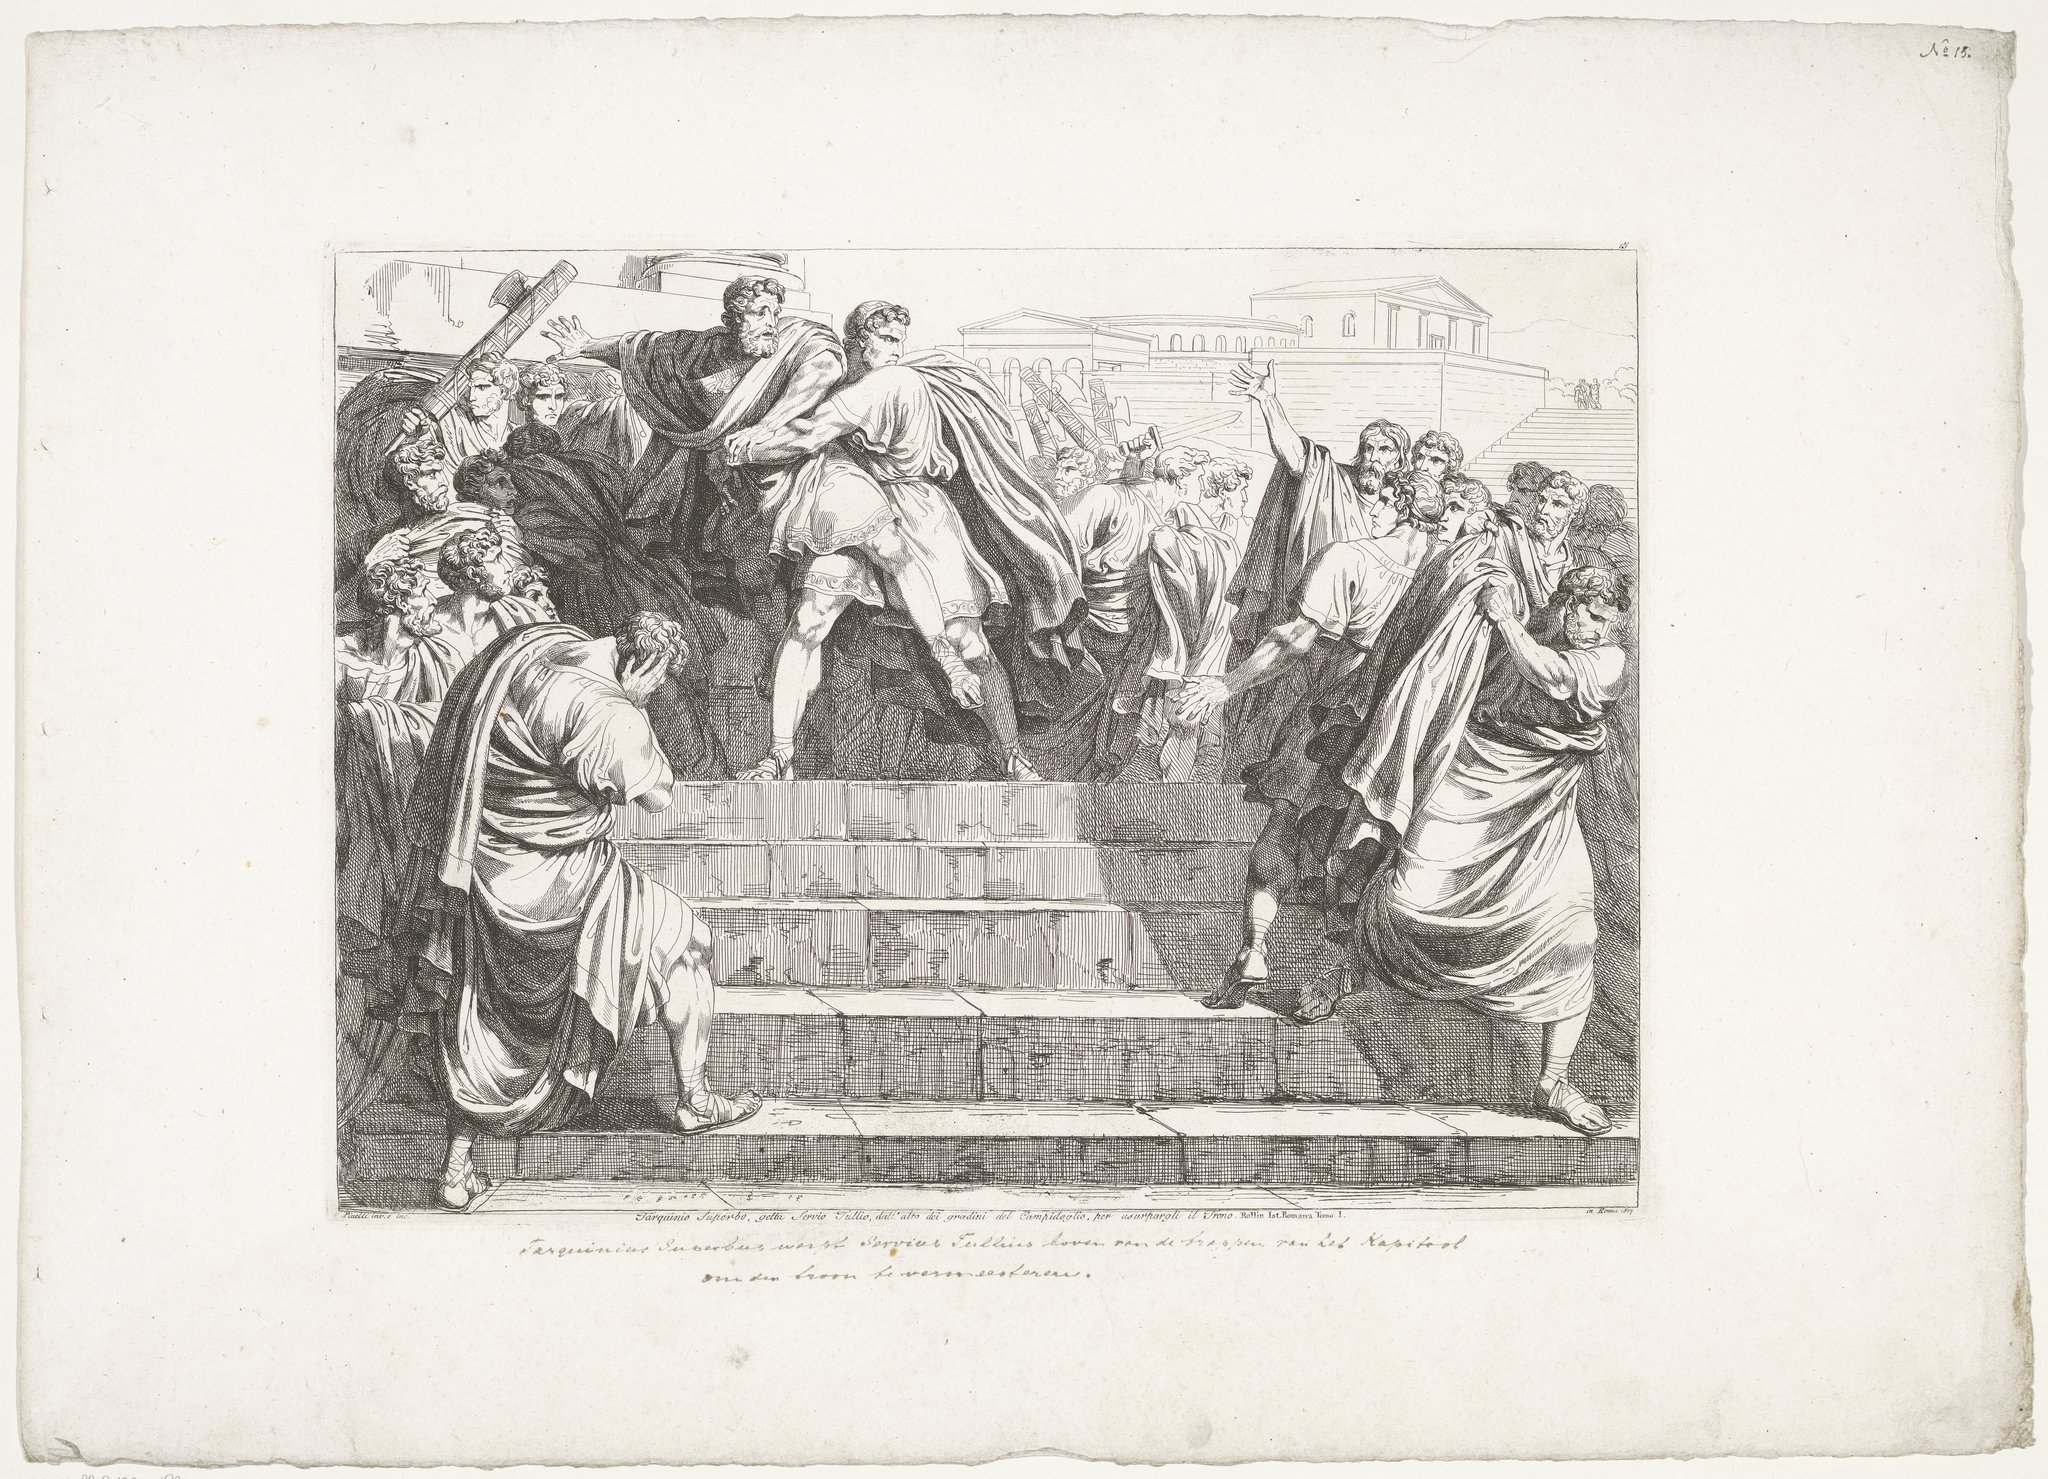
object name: print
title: Frontespizio della Istoria Romana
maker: bartolomeo pinelli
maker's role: draughtsman, print maker, sculptor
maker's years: 1781-1835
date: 1817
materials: paper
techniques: etching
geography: rome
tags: (story of) tarquinius superbus, (story of) tarquinius superbus - aggressive relationships of person from classical history, rome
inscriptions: collector's mark: Lugt 2228, number: ‘No 15.’, inscription: ‘Tarquinius Superbus werpt Servius Tullius boven van de trappen van het Kapitool / om den troon te vermeesteren.’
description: Tarquinius Superbus werpt Servius Tullius van de trappen van het Capitool te Rome. Andere mannen kijken toe.